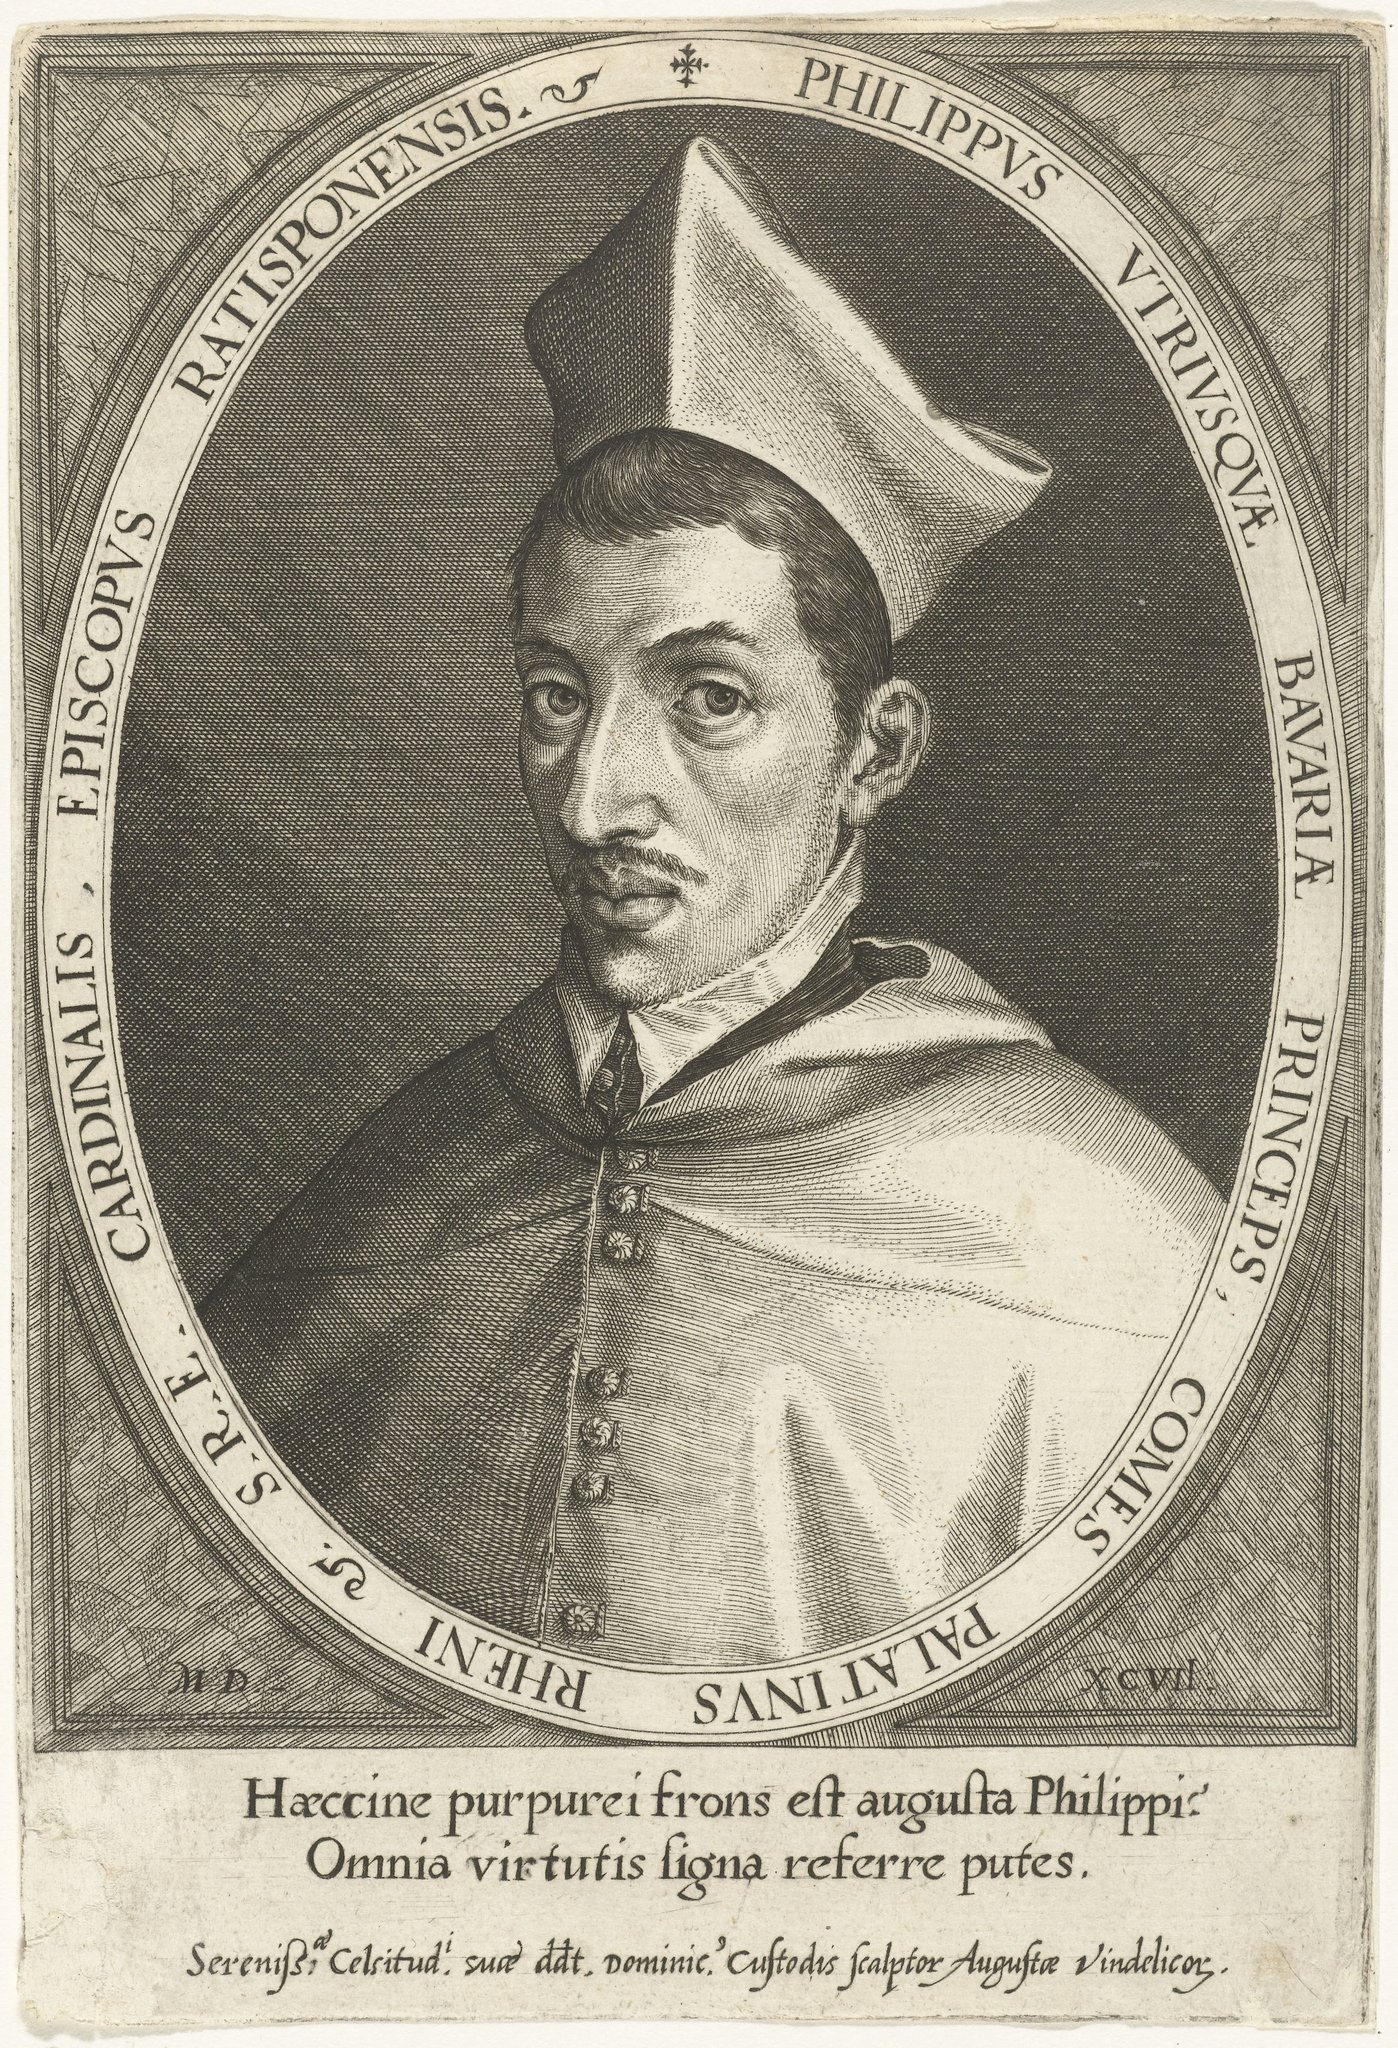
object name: print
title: Portretten van bekende personen uit de zestiende eeuw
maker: dominicus custos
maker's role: print maker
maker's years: 1560-1615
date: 1597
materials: paper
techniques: engraving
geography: augsburg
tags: bisschop van regensburg philip willem van beieren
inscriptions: collector's mark: Lugt 2228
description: Illustratie uit: D. Custos en M. Henning. Atrium heroicum Caesarum, regum aliorq. summatum ac procerum qui intra proximum seculum vixere, aut hodie supersunt, imaginib. Deel 1-4. Augsburg: D. Custos, 1600-1604.